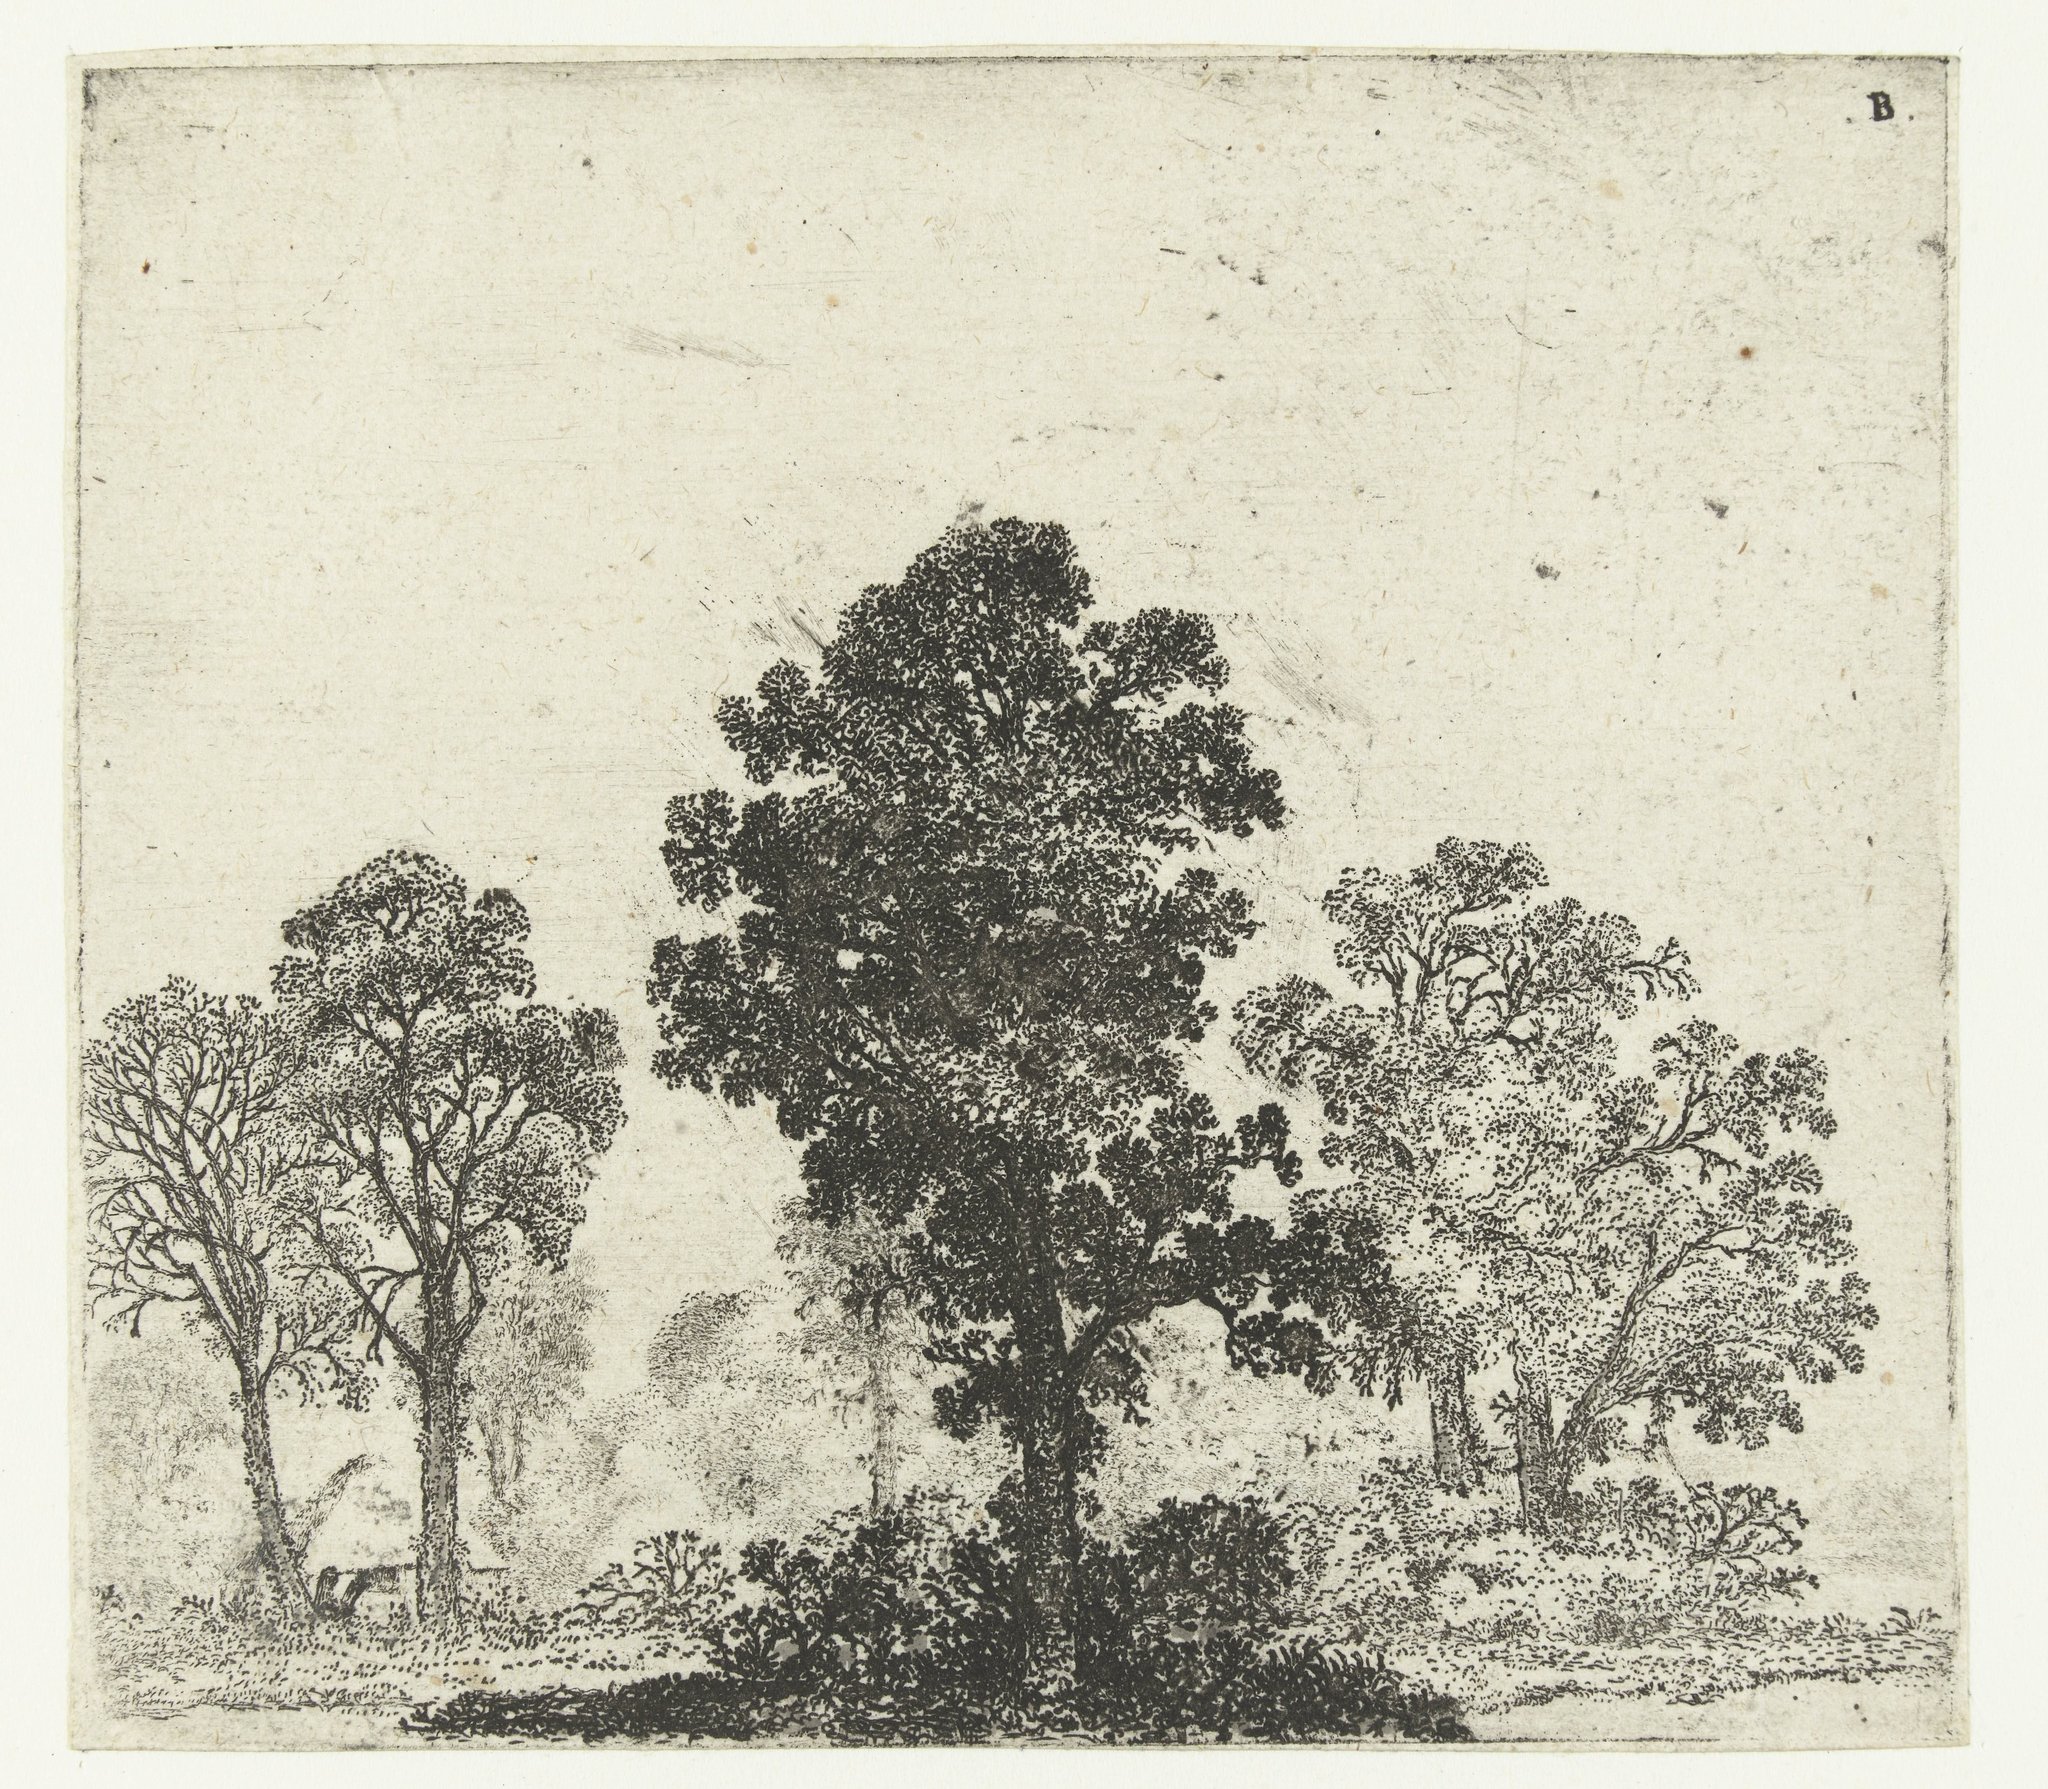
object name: print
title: Landschap met boom in het midden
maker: jan van brosterhuyzen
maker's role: draughtsman, print maker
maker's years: 1596-1650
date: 1610-1650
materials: paper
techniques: etching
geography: netherlands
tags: landscapes in the temperate zone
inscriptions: collector's mark: Lugt 2228a